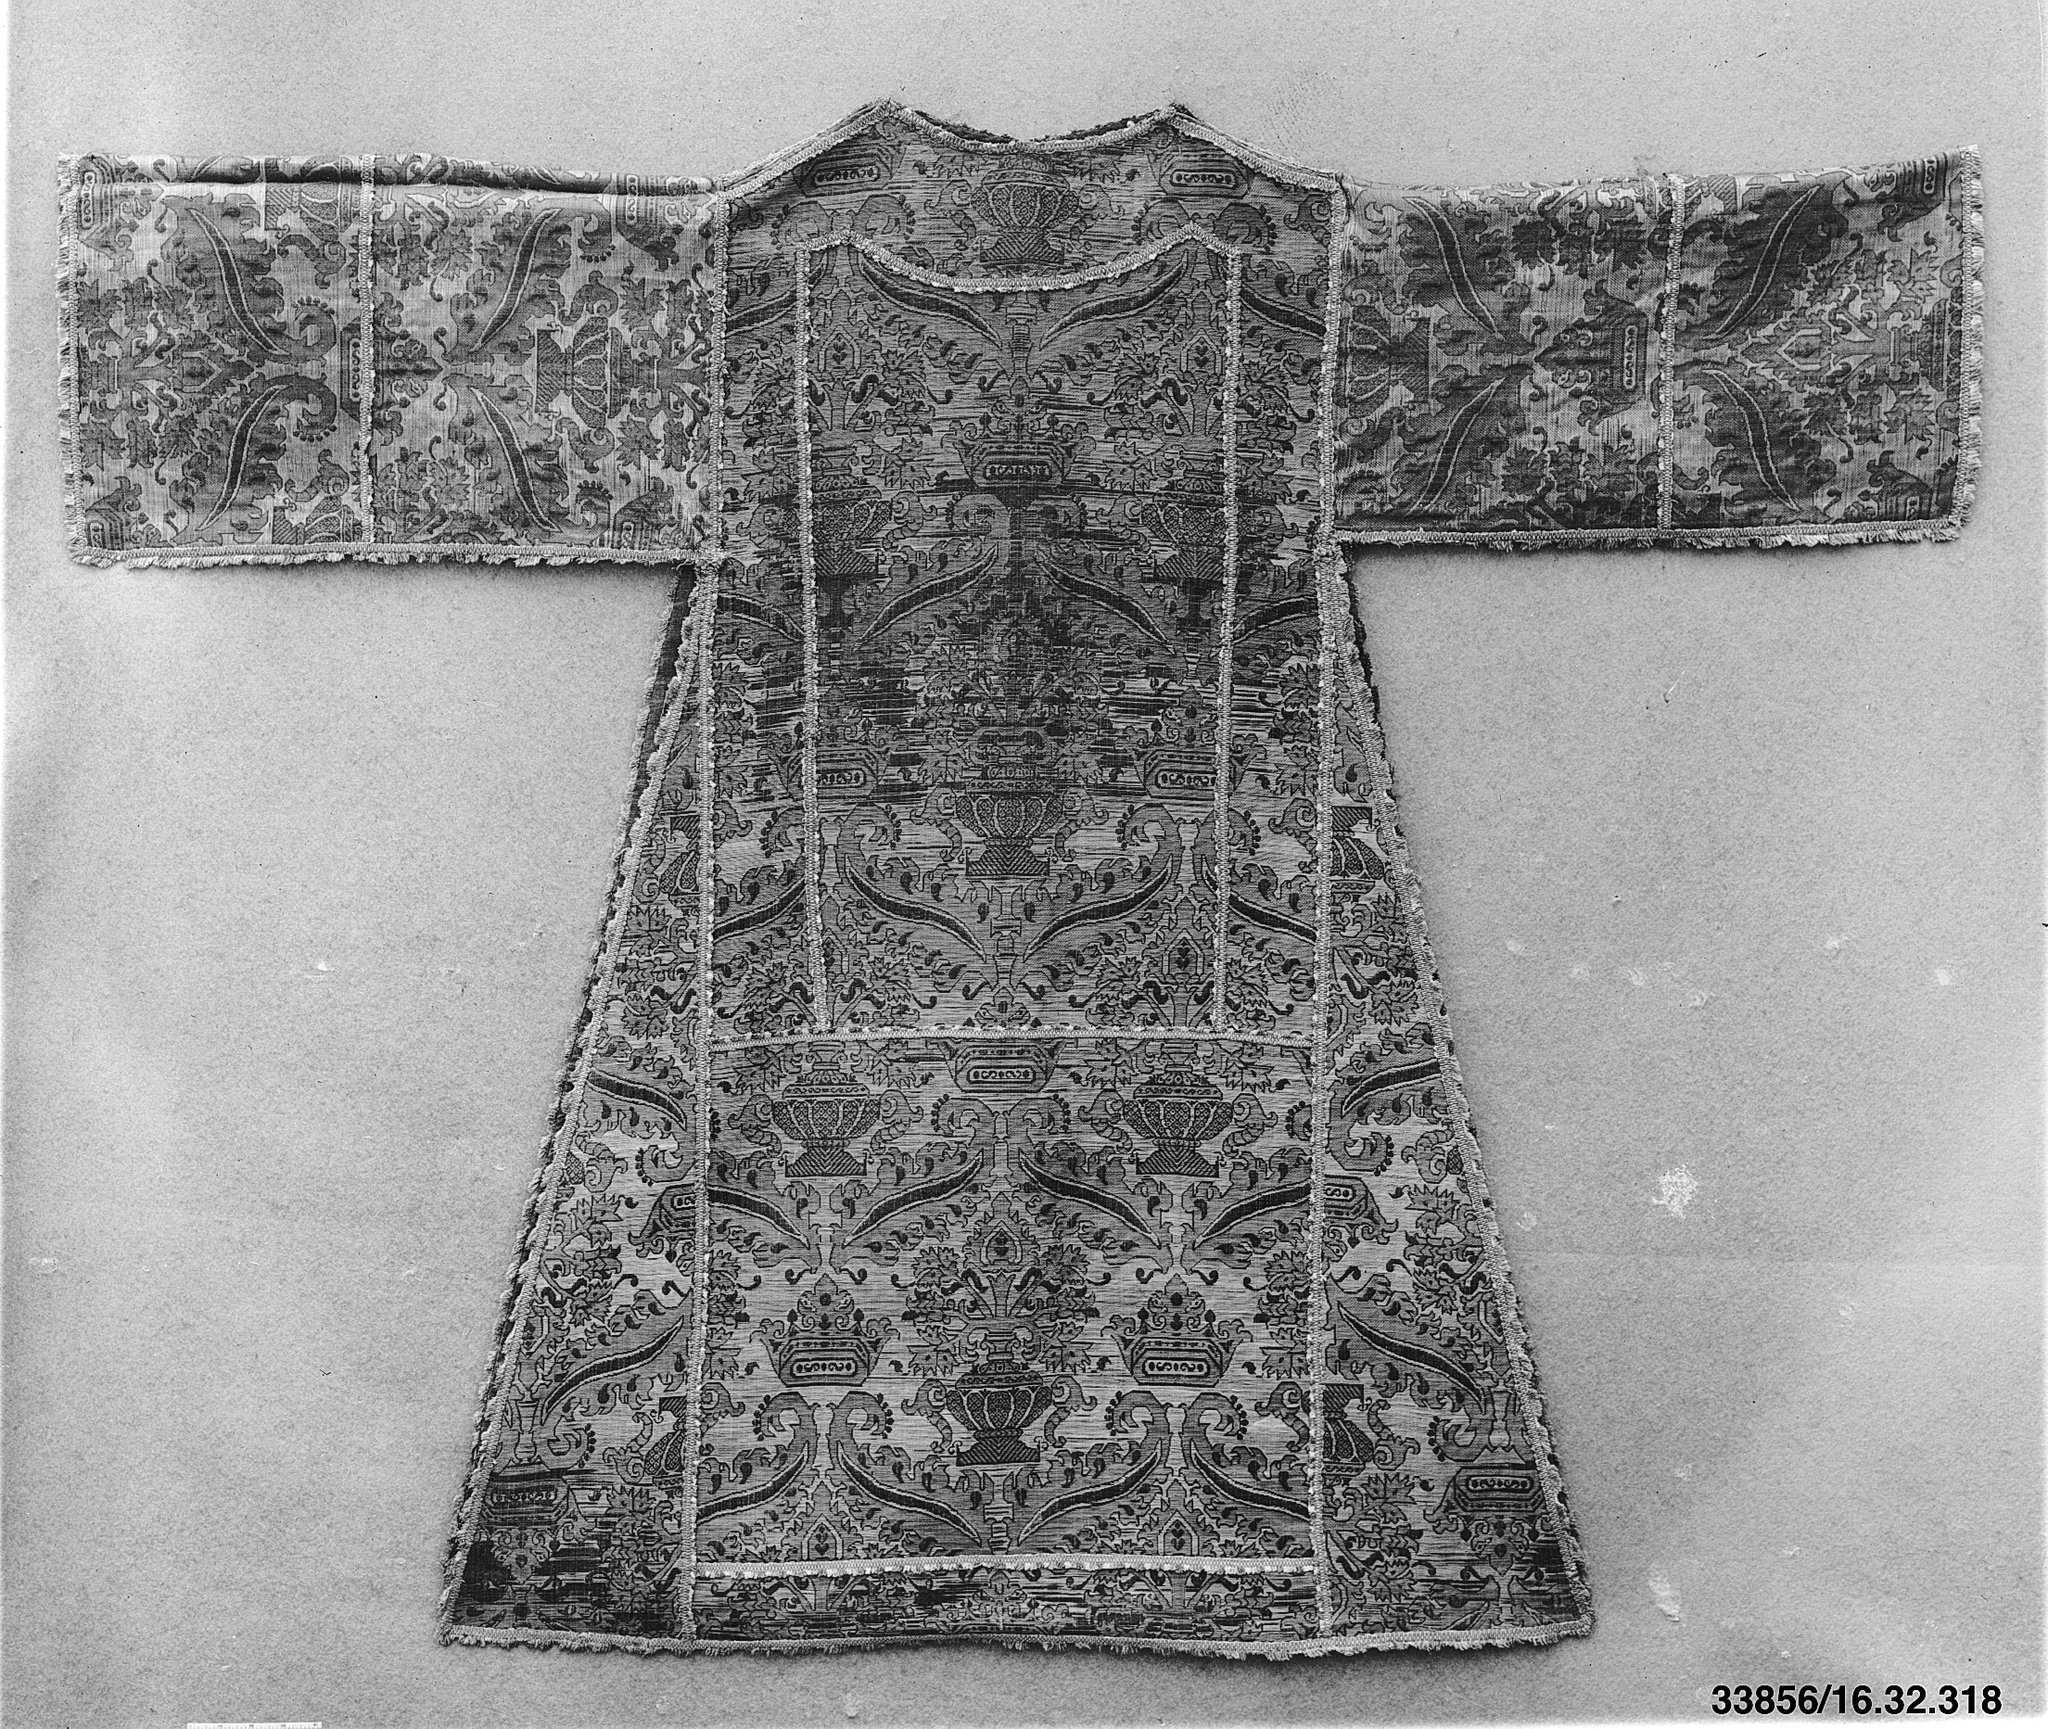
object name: dalmatic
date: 1501-1600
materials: silk